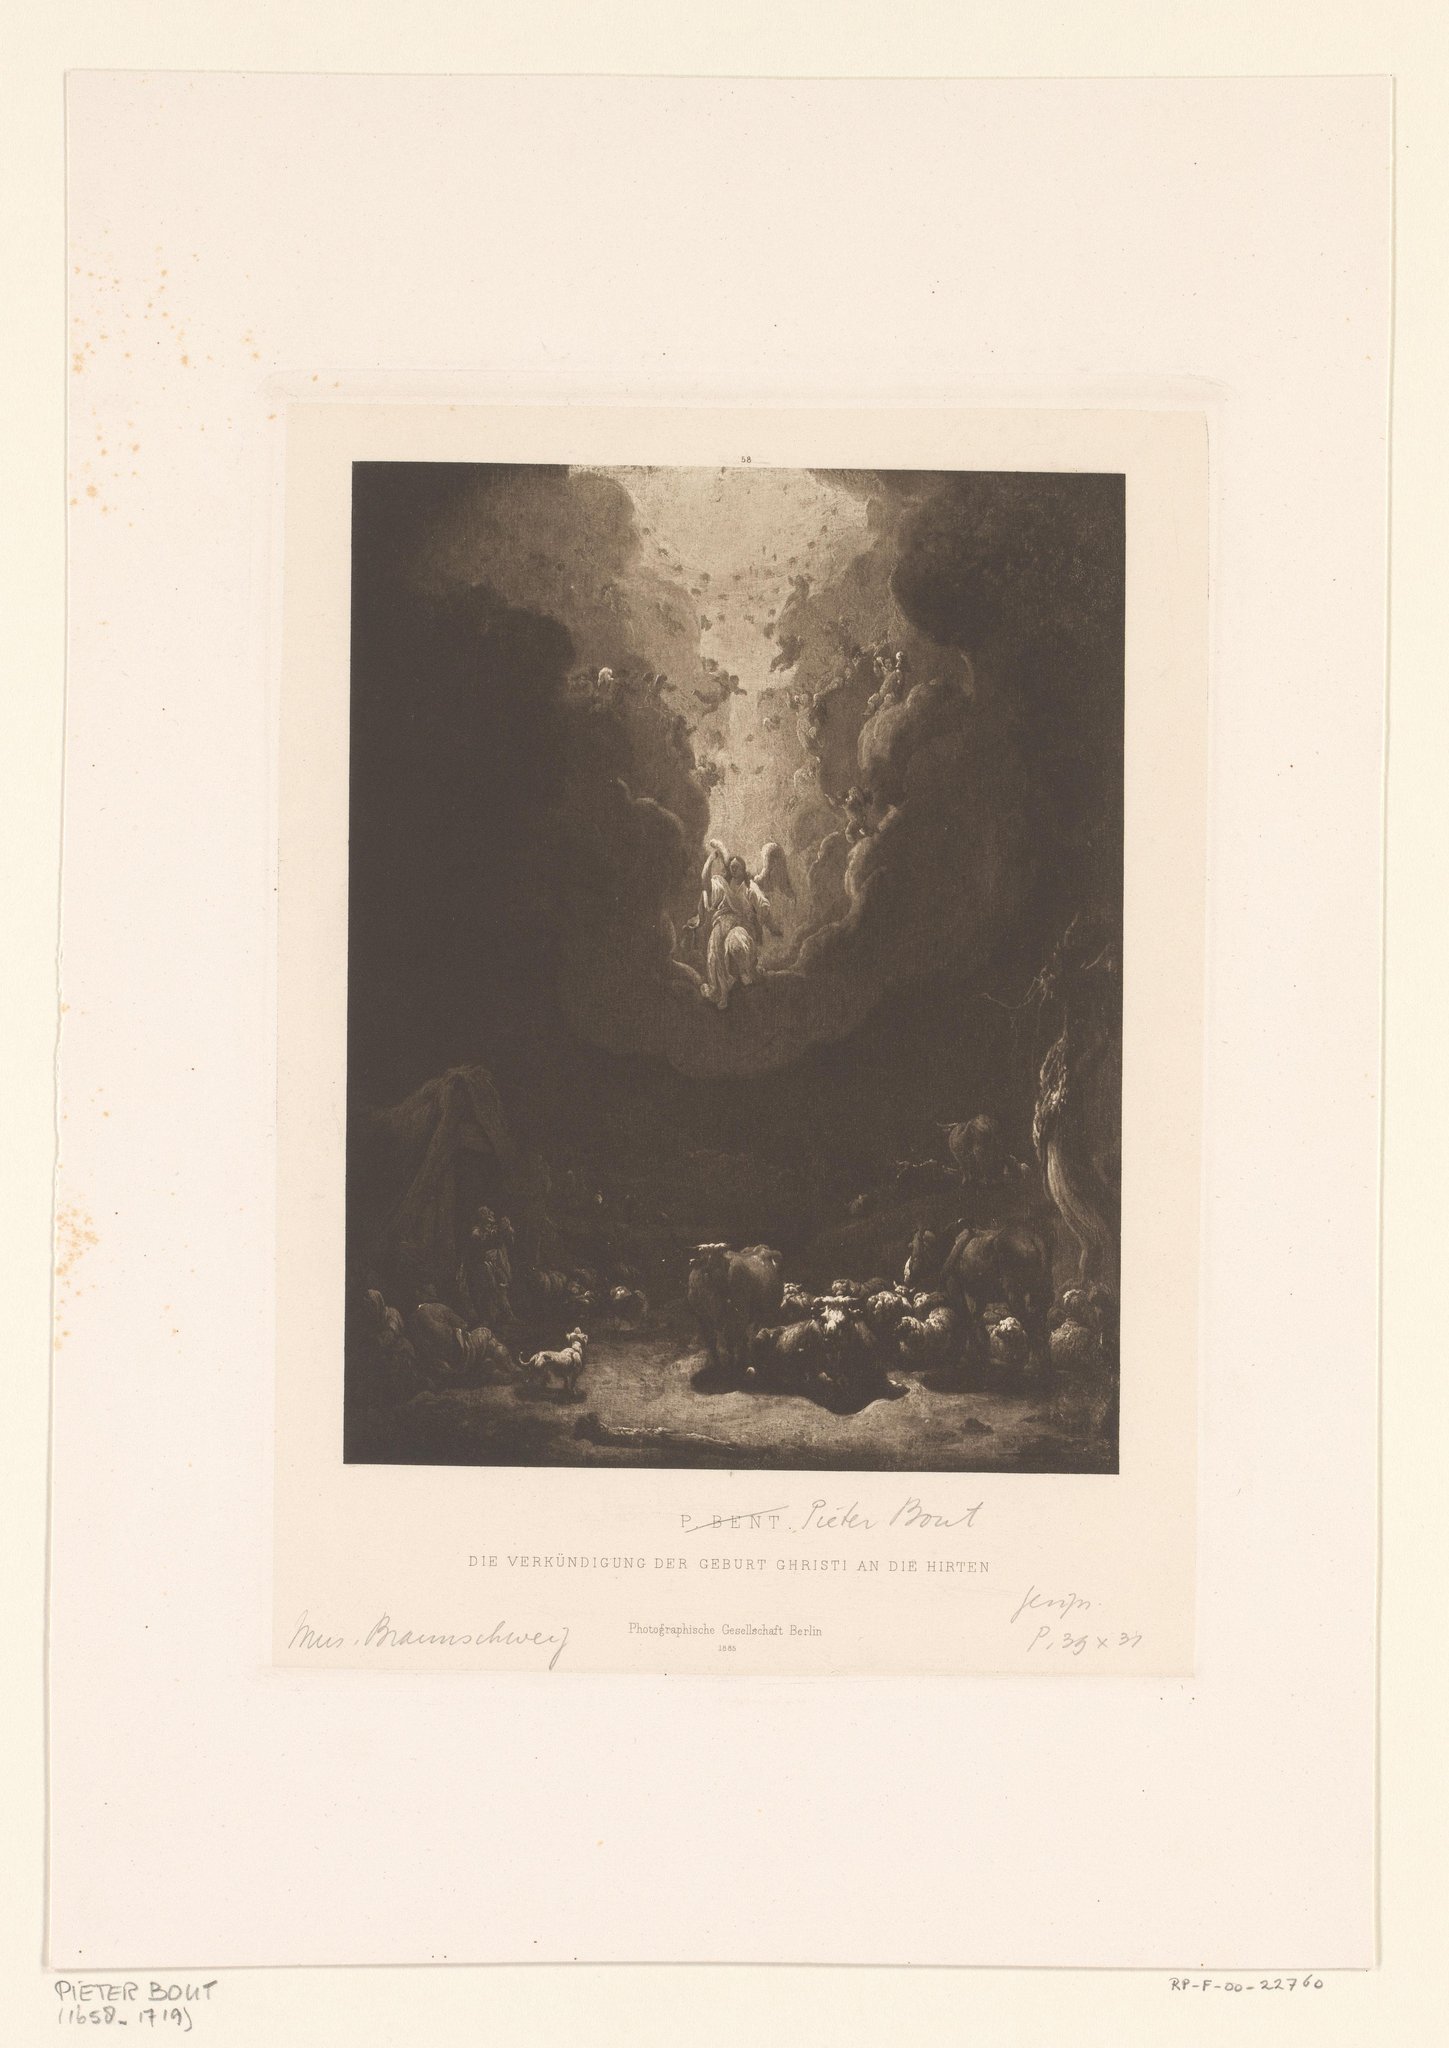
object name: photomechanical print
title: Fotoreproductie van de prent De verkondiging aan de herders door Pieter Bout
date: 1885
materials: paper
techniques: photoaquatint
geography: berlin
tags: annunciation of christ's birth to the shepherds (and/or shepherdesses) at night; a host of singing angels in the air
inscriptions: inscription: ‘P. Bent/ Pieter Bout/ Mus. Braunschweig/ genn./ P. 39 x 31’, stamp: ‘ICON’, collector's mark: Lugt 2228a, number: ‘58’, stamp: ‘Photographische/ Berlin/ Gesellschaft’